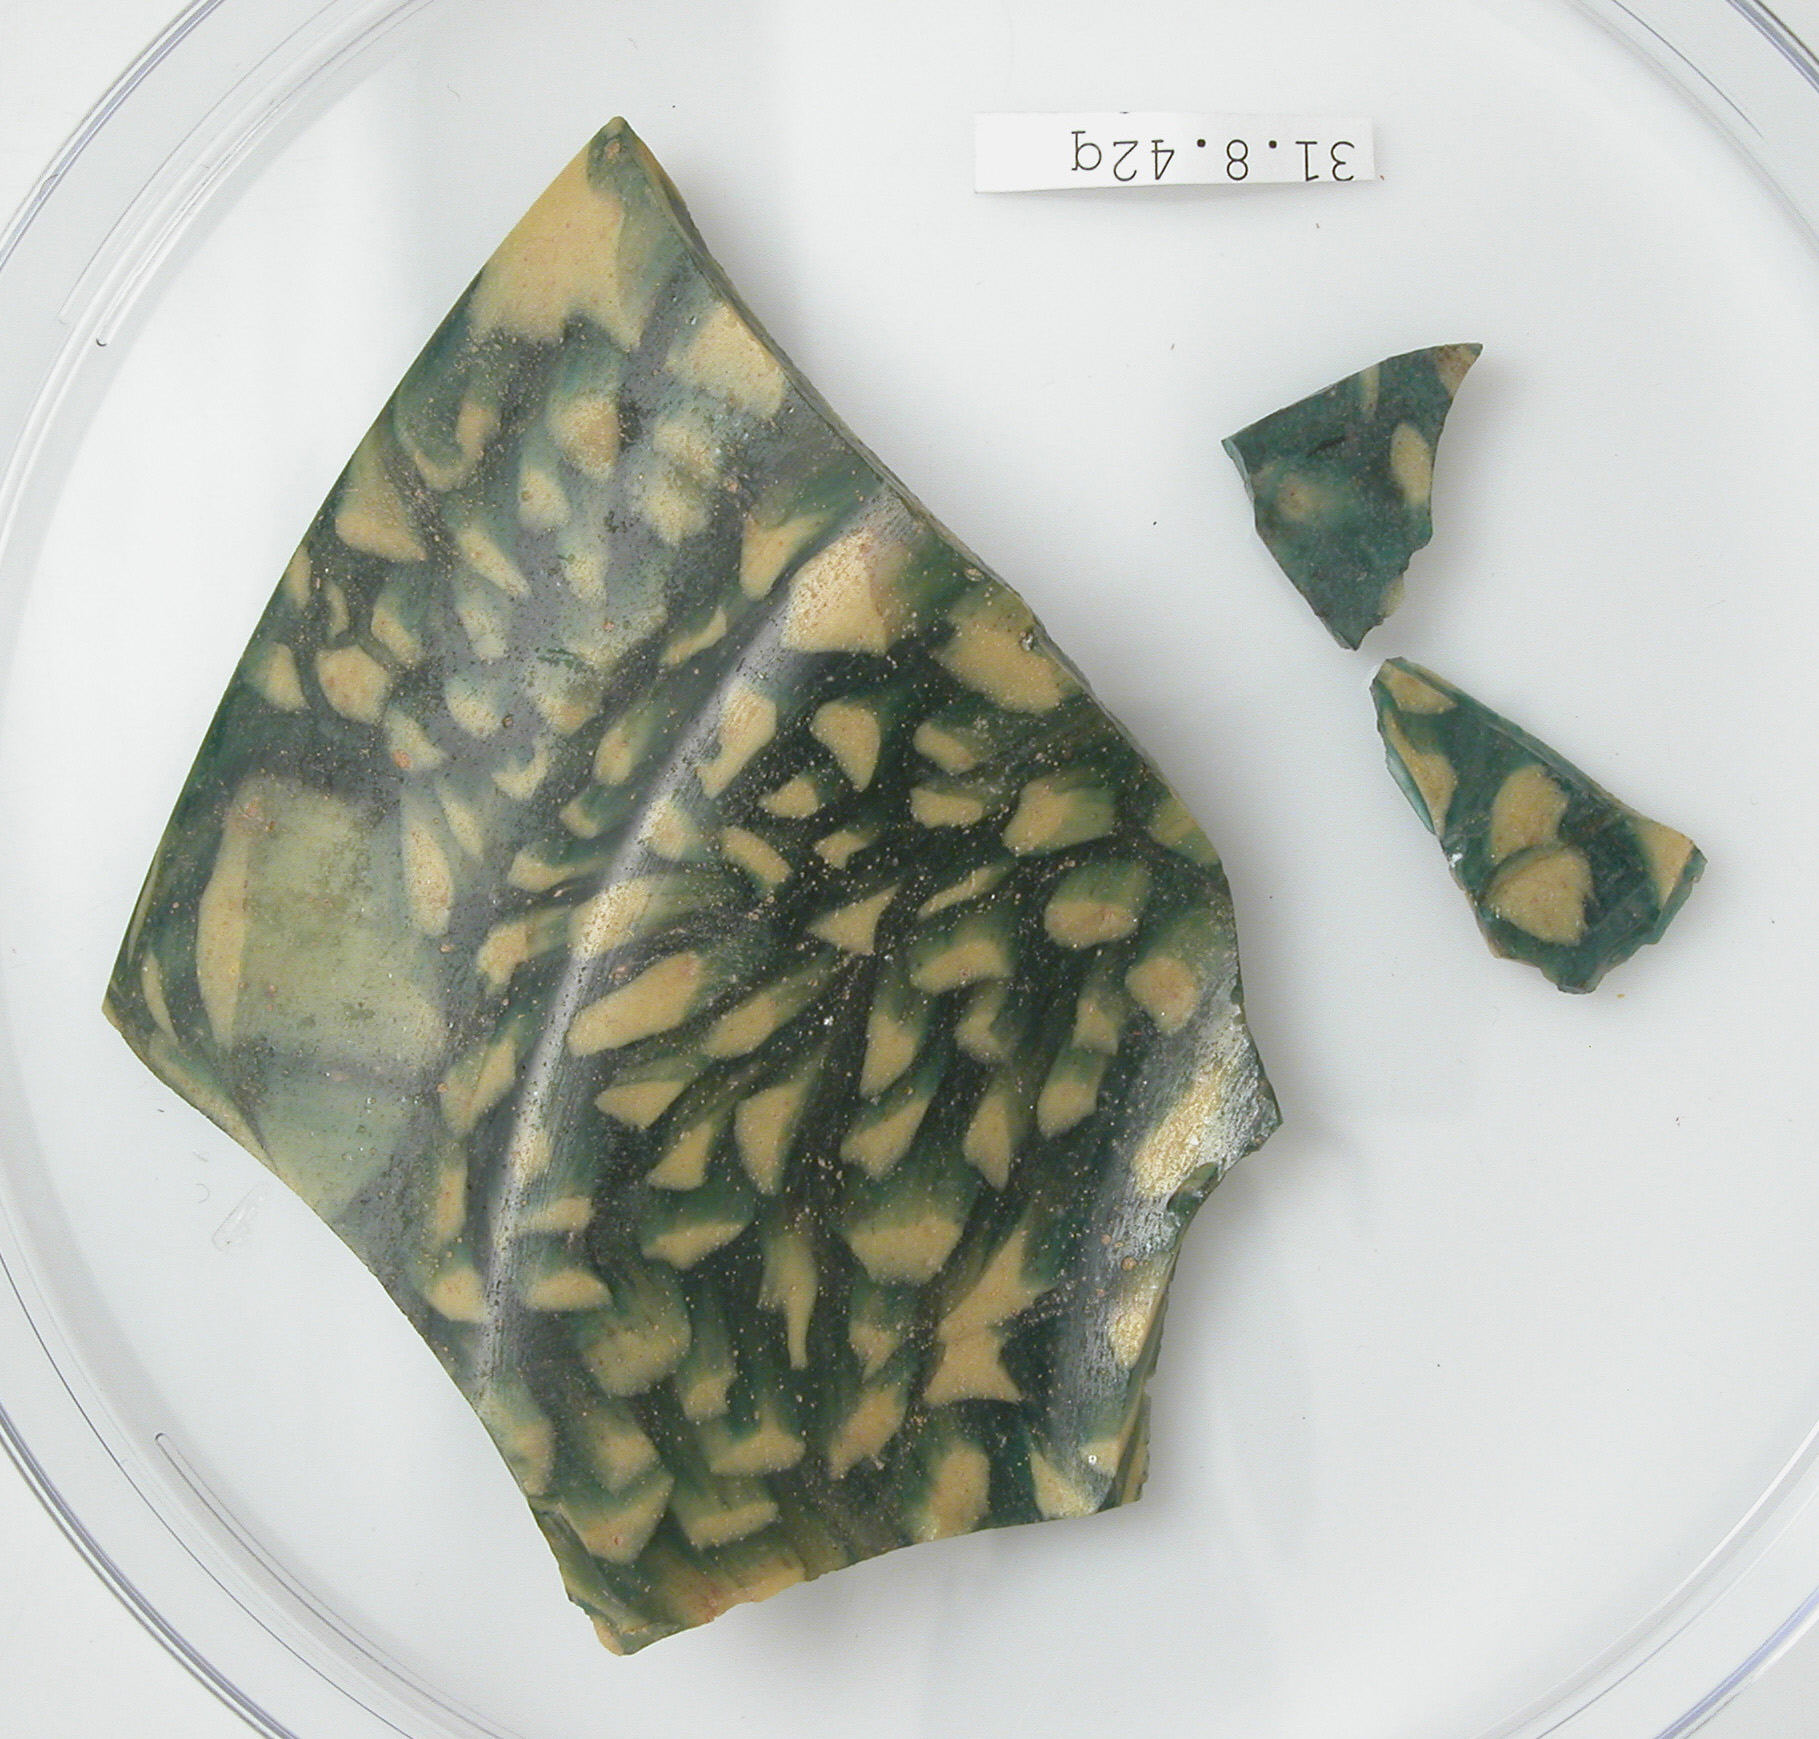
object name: fragment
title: Glass Fragments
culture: coptic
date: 301-400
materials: glass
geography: egypt